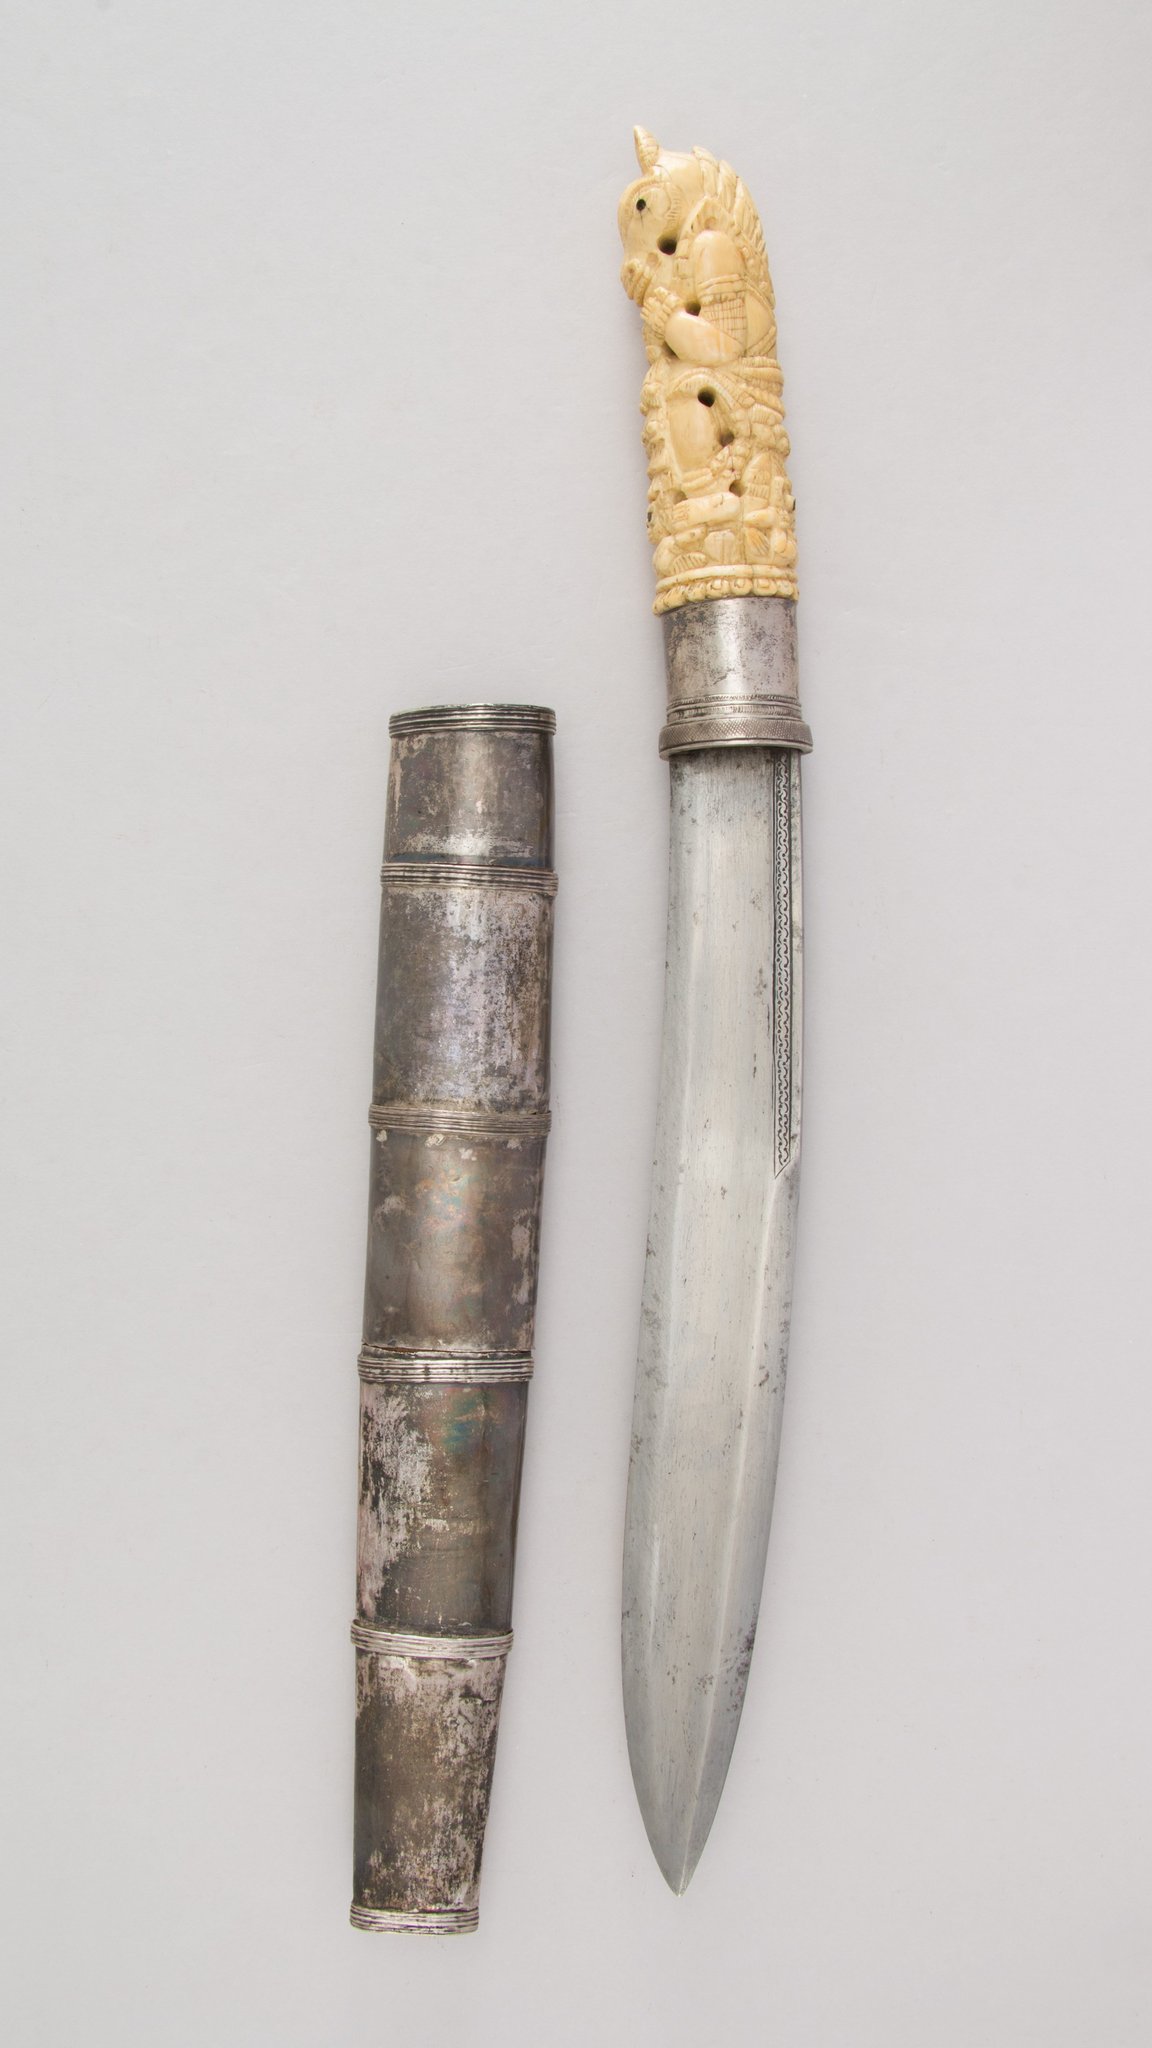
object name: dagger dha with sheath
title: Dagger (Dha) with Sheath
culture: burmese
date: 1701-1800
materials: bone, silver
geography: burma